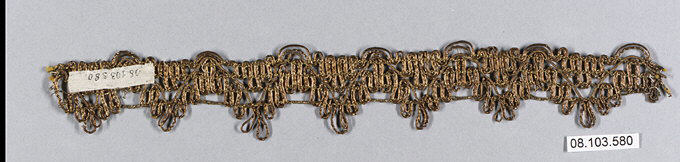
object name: galloon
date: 1601-1800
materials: metal thread